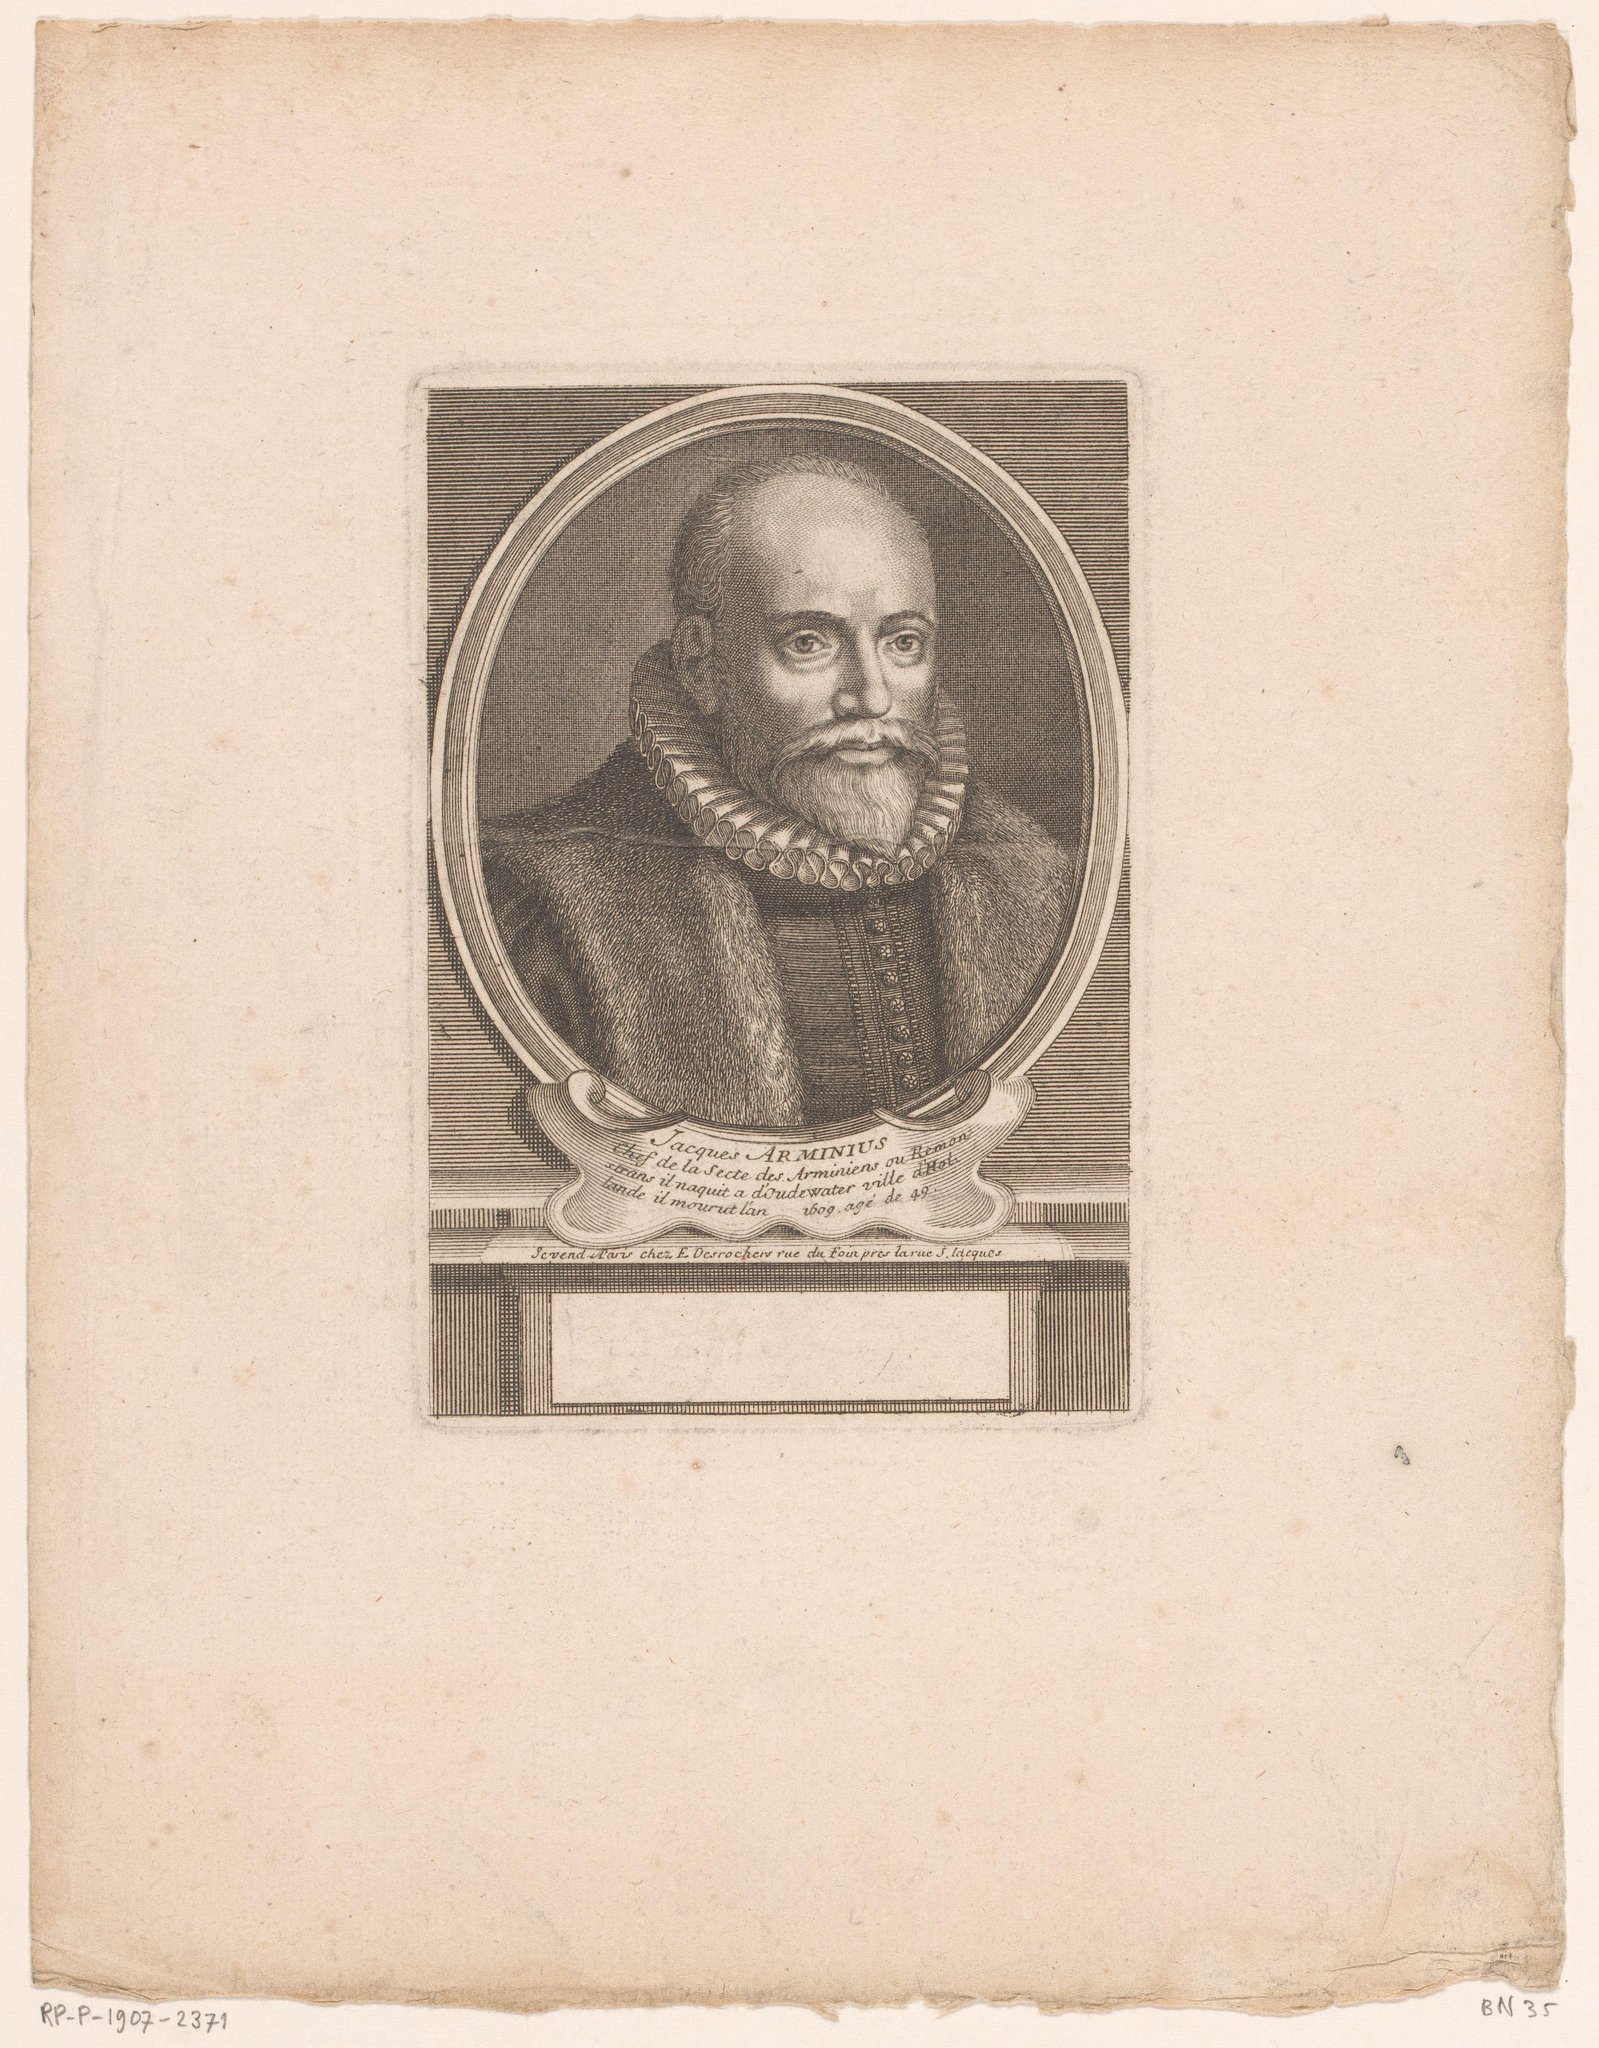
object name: print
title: Verzameling portretten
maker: étienne desrochers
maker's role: print maker, publisher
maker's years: 1668-1741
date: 1726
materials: paper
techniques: engraving, etching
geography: paris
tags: leiden, historical persons, professor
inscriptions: collector's mark: Lugt 2228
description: Behoort waarschijnlijk tot een serie portretten, grotendeels door Etienne Desrochers, getiteld: 'Recueil de portraits de personnes qui se sont distinguées tant dans les Armes que dans Belles-Lettres et les Arts, comme aussi la famille royale de France et autres cours étrangères'. De serie werd initieel uitgegeven door Desrochers en aangekondigd in 'Mercure' in mei 1726, p. 985. Echter was Desrochers reeds enkele jaren eerder begonnen met het uitgeven van de serie. Na de dood van Desrochers werd de serie voortgezet door Gilles Edme Petit. Een latere staat werd uitgegeven door Jean François Daumont in Parijs.